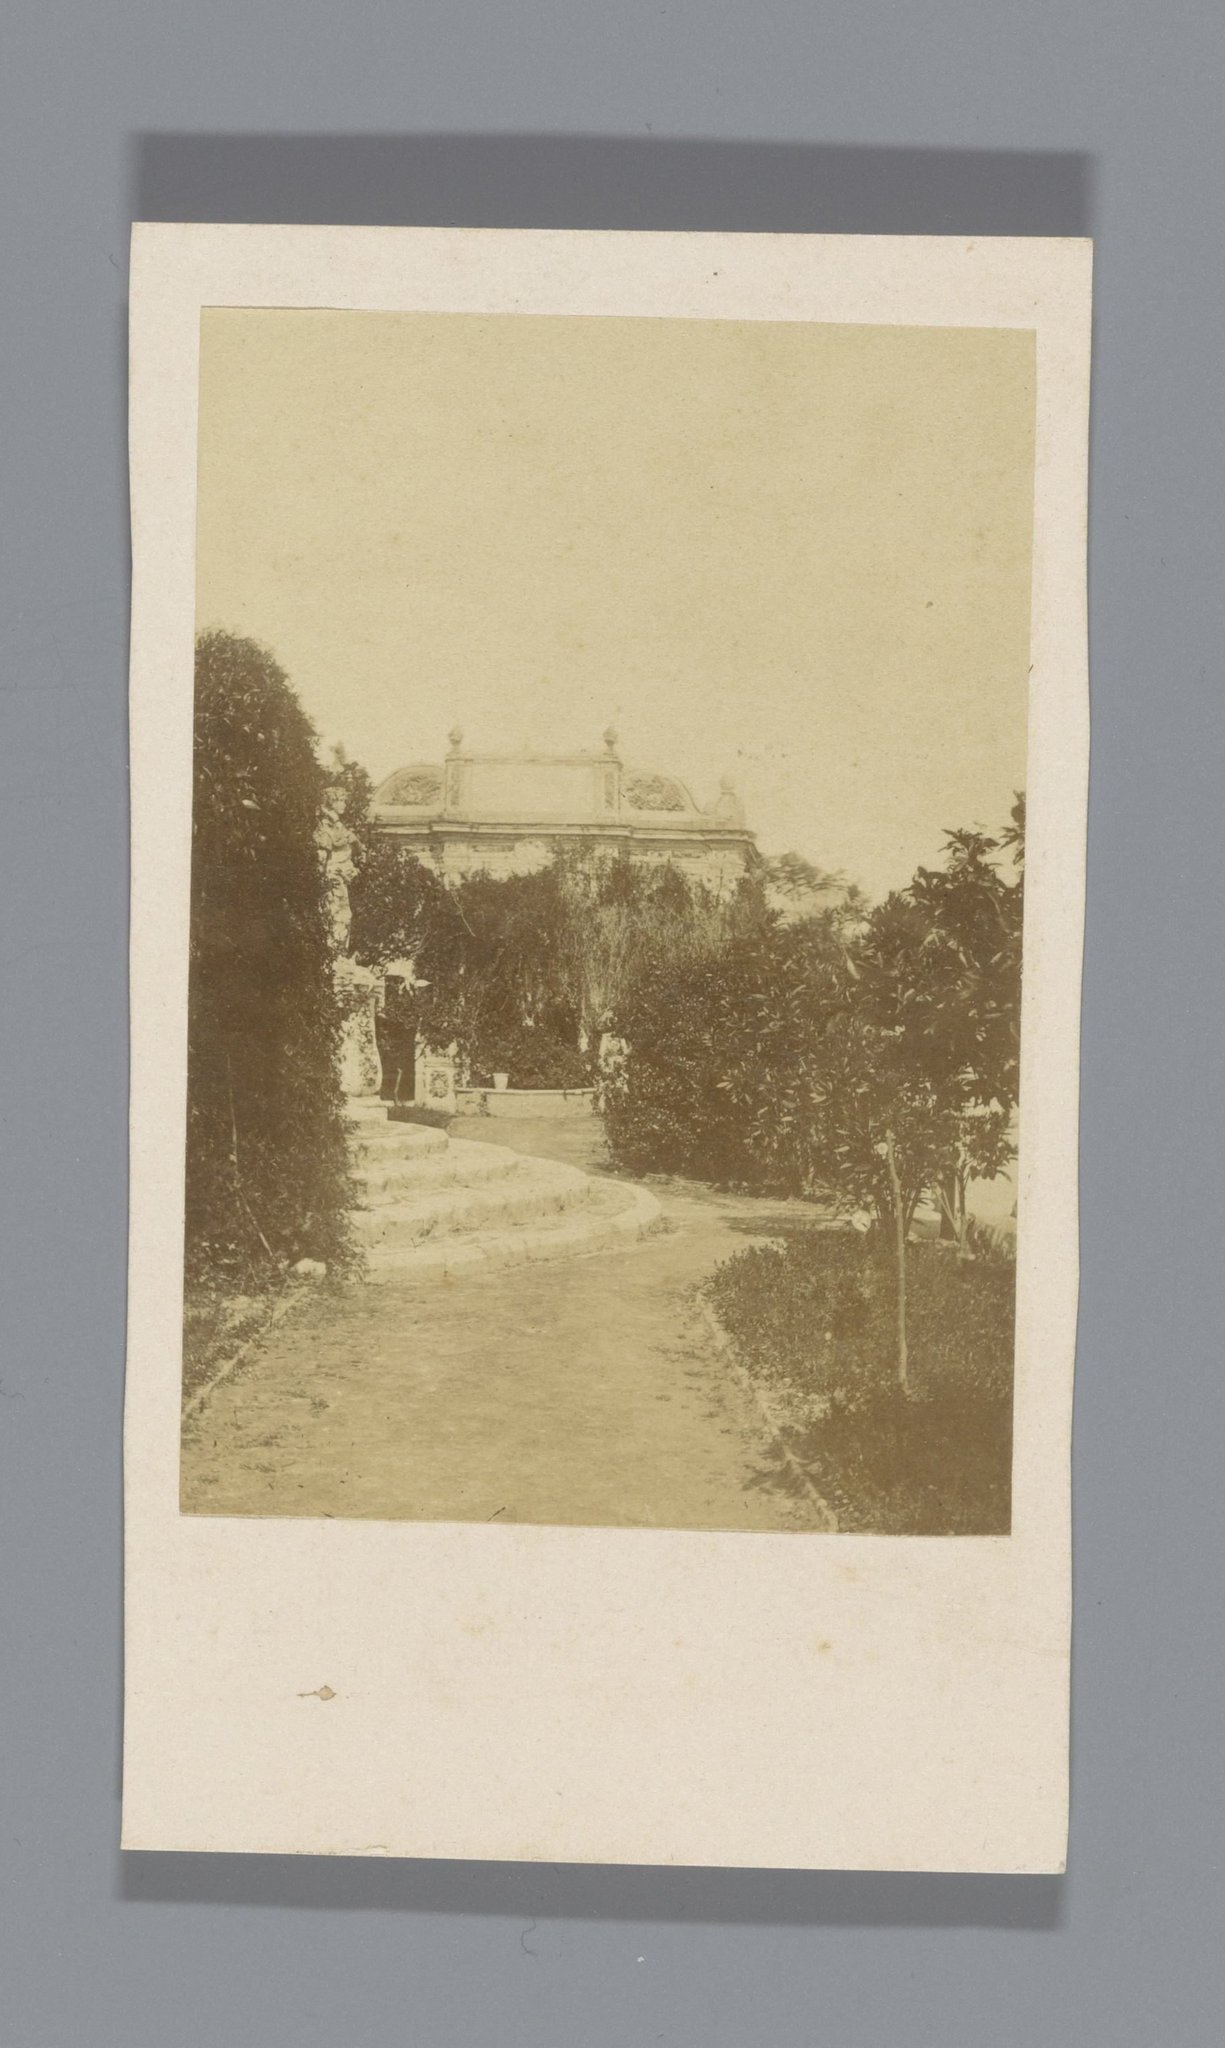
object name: photograph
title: Villa in Nice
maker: Anonymous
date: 1865-1870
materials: cardboard, paper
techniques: albumen print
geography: nice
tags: villa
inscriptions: inscription: ‘Villa à Nice’